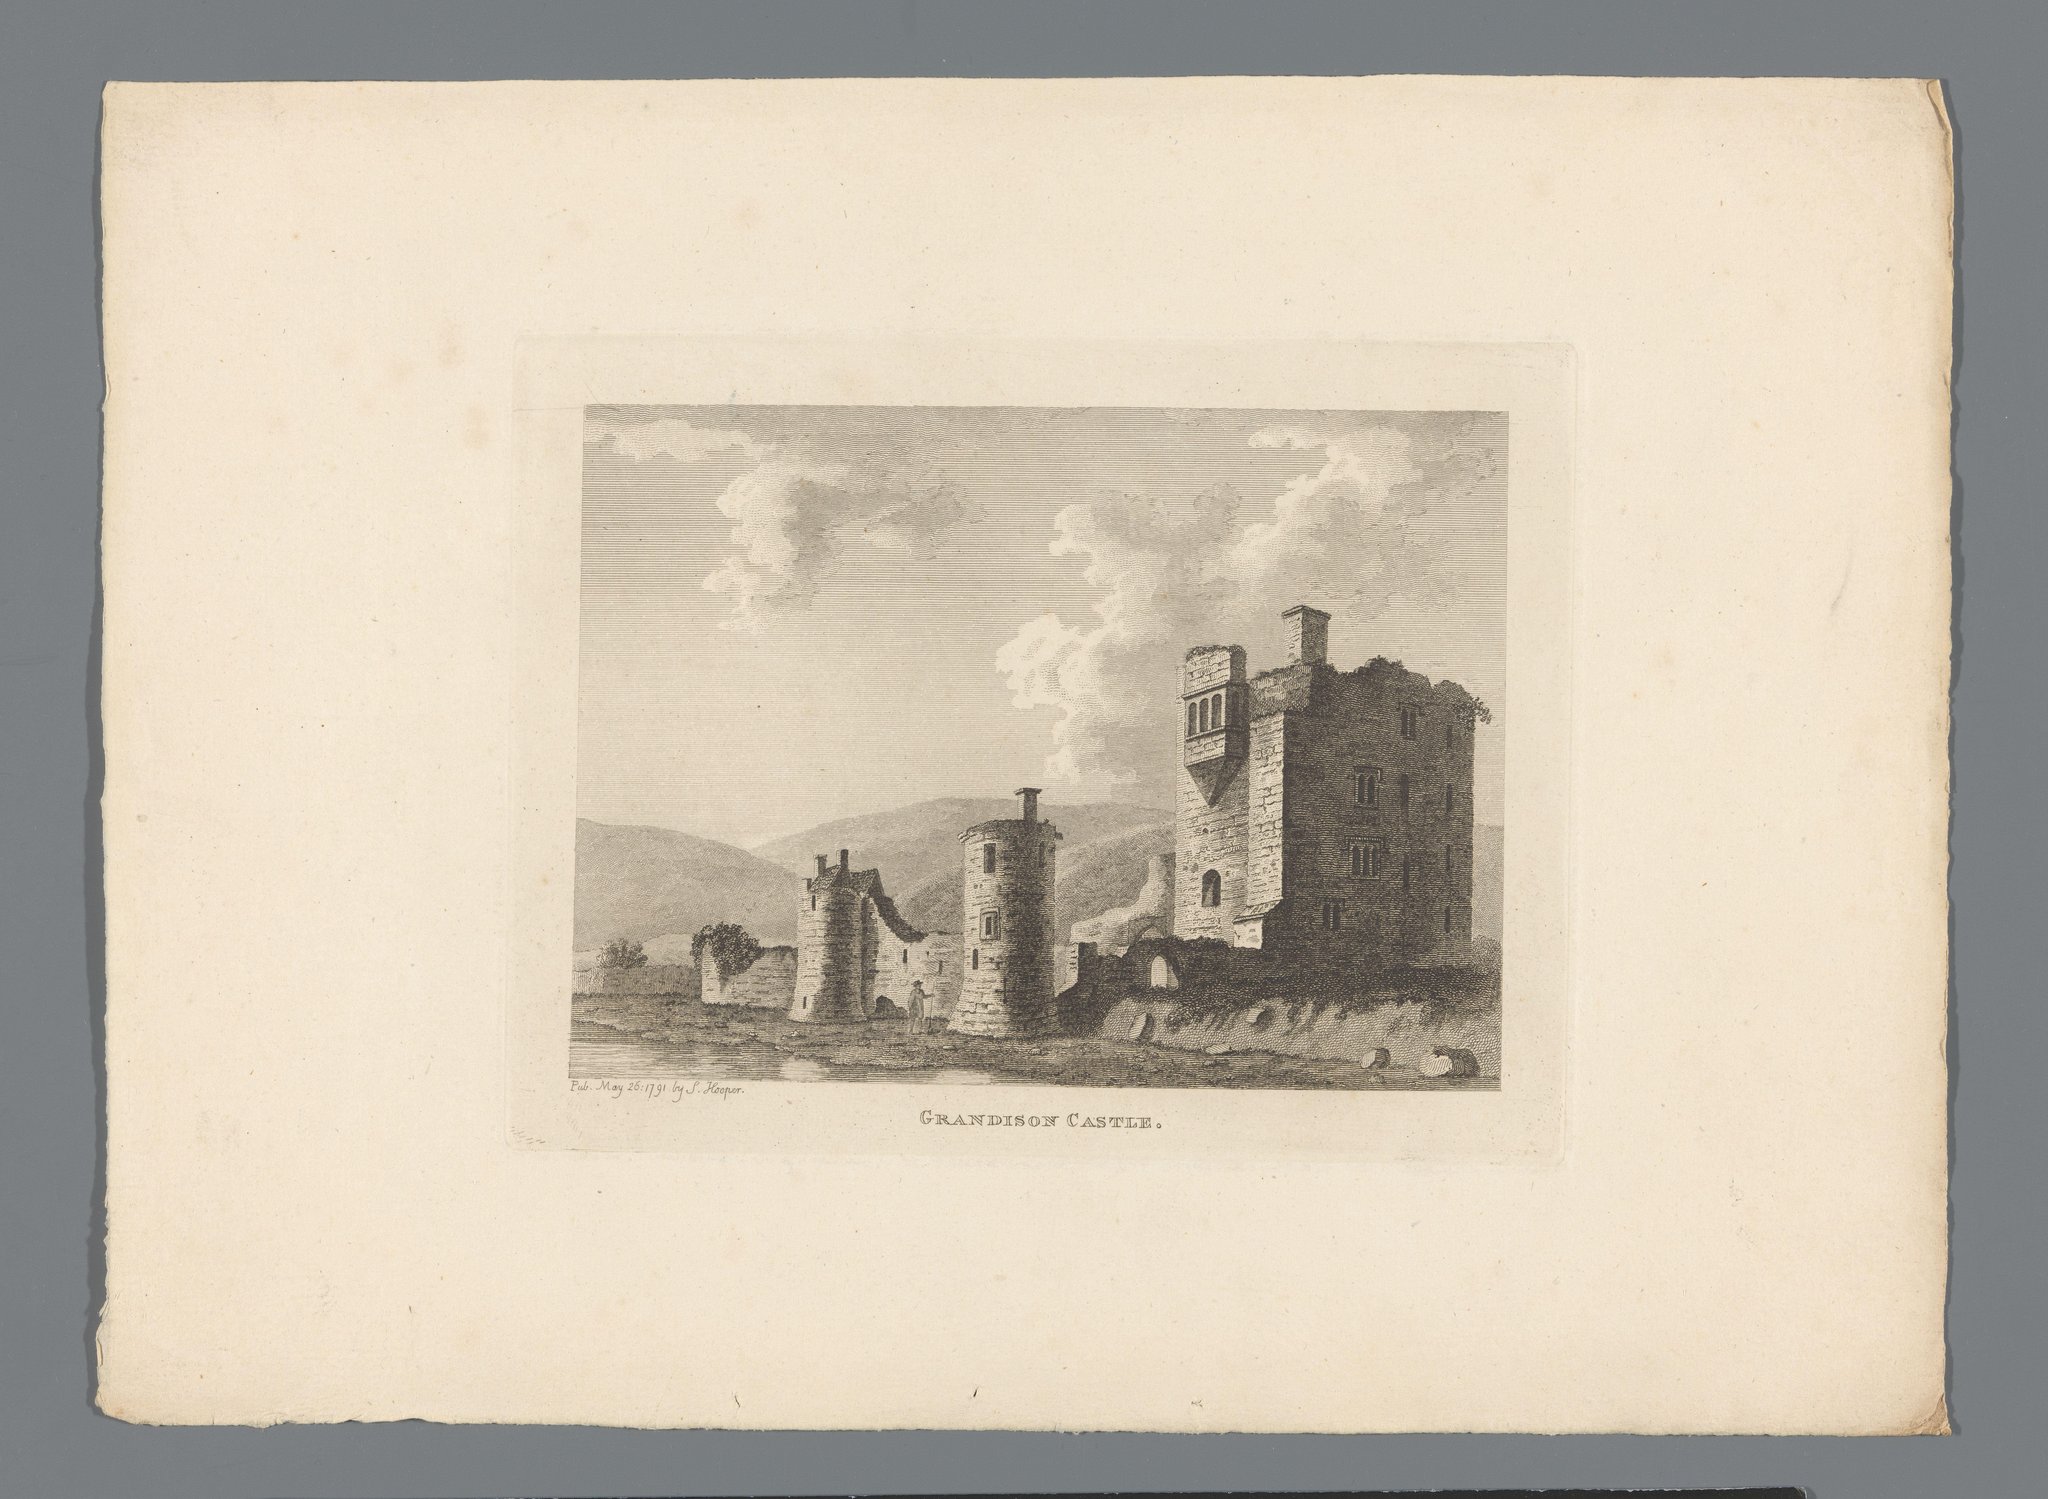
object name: print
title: Grandison Castle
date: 1791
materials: paper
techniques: etching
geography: london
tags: landscape with ruins, landscape with tower or castle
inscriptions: date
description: Prent verschenen in: Grose, Francis. The antiquities of Ireland. Londen: S. Hooper, 1795, dl. 2.